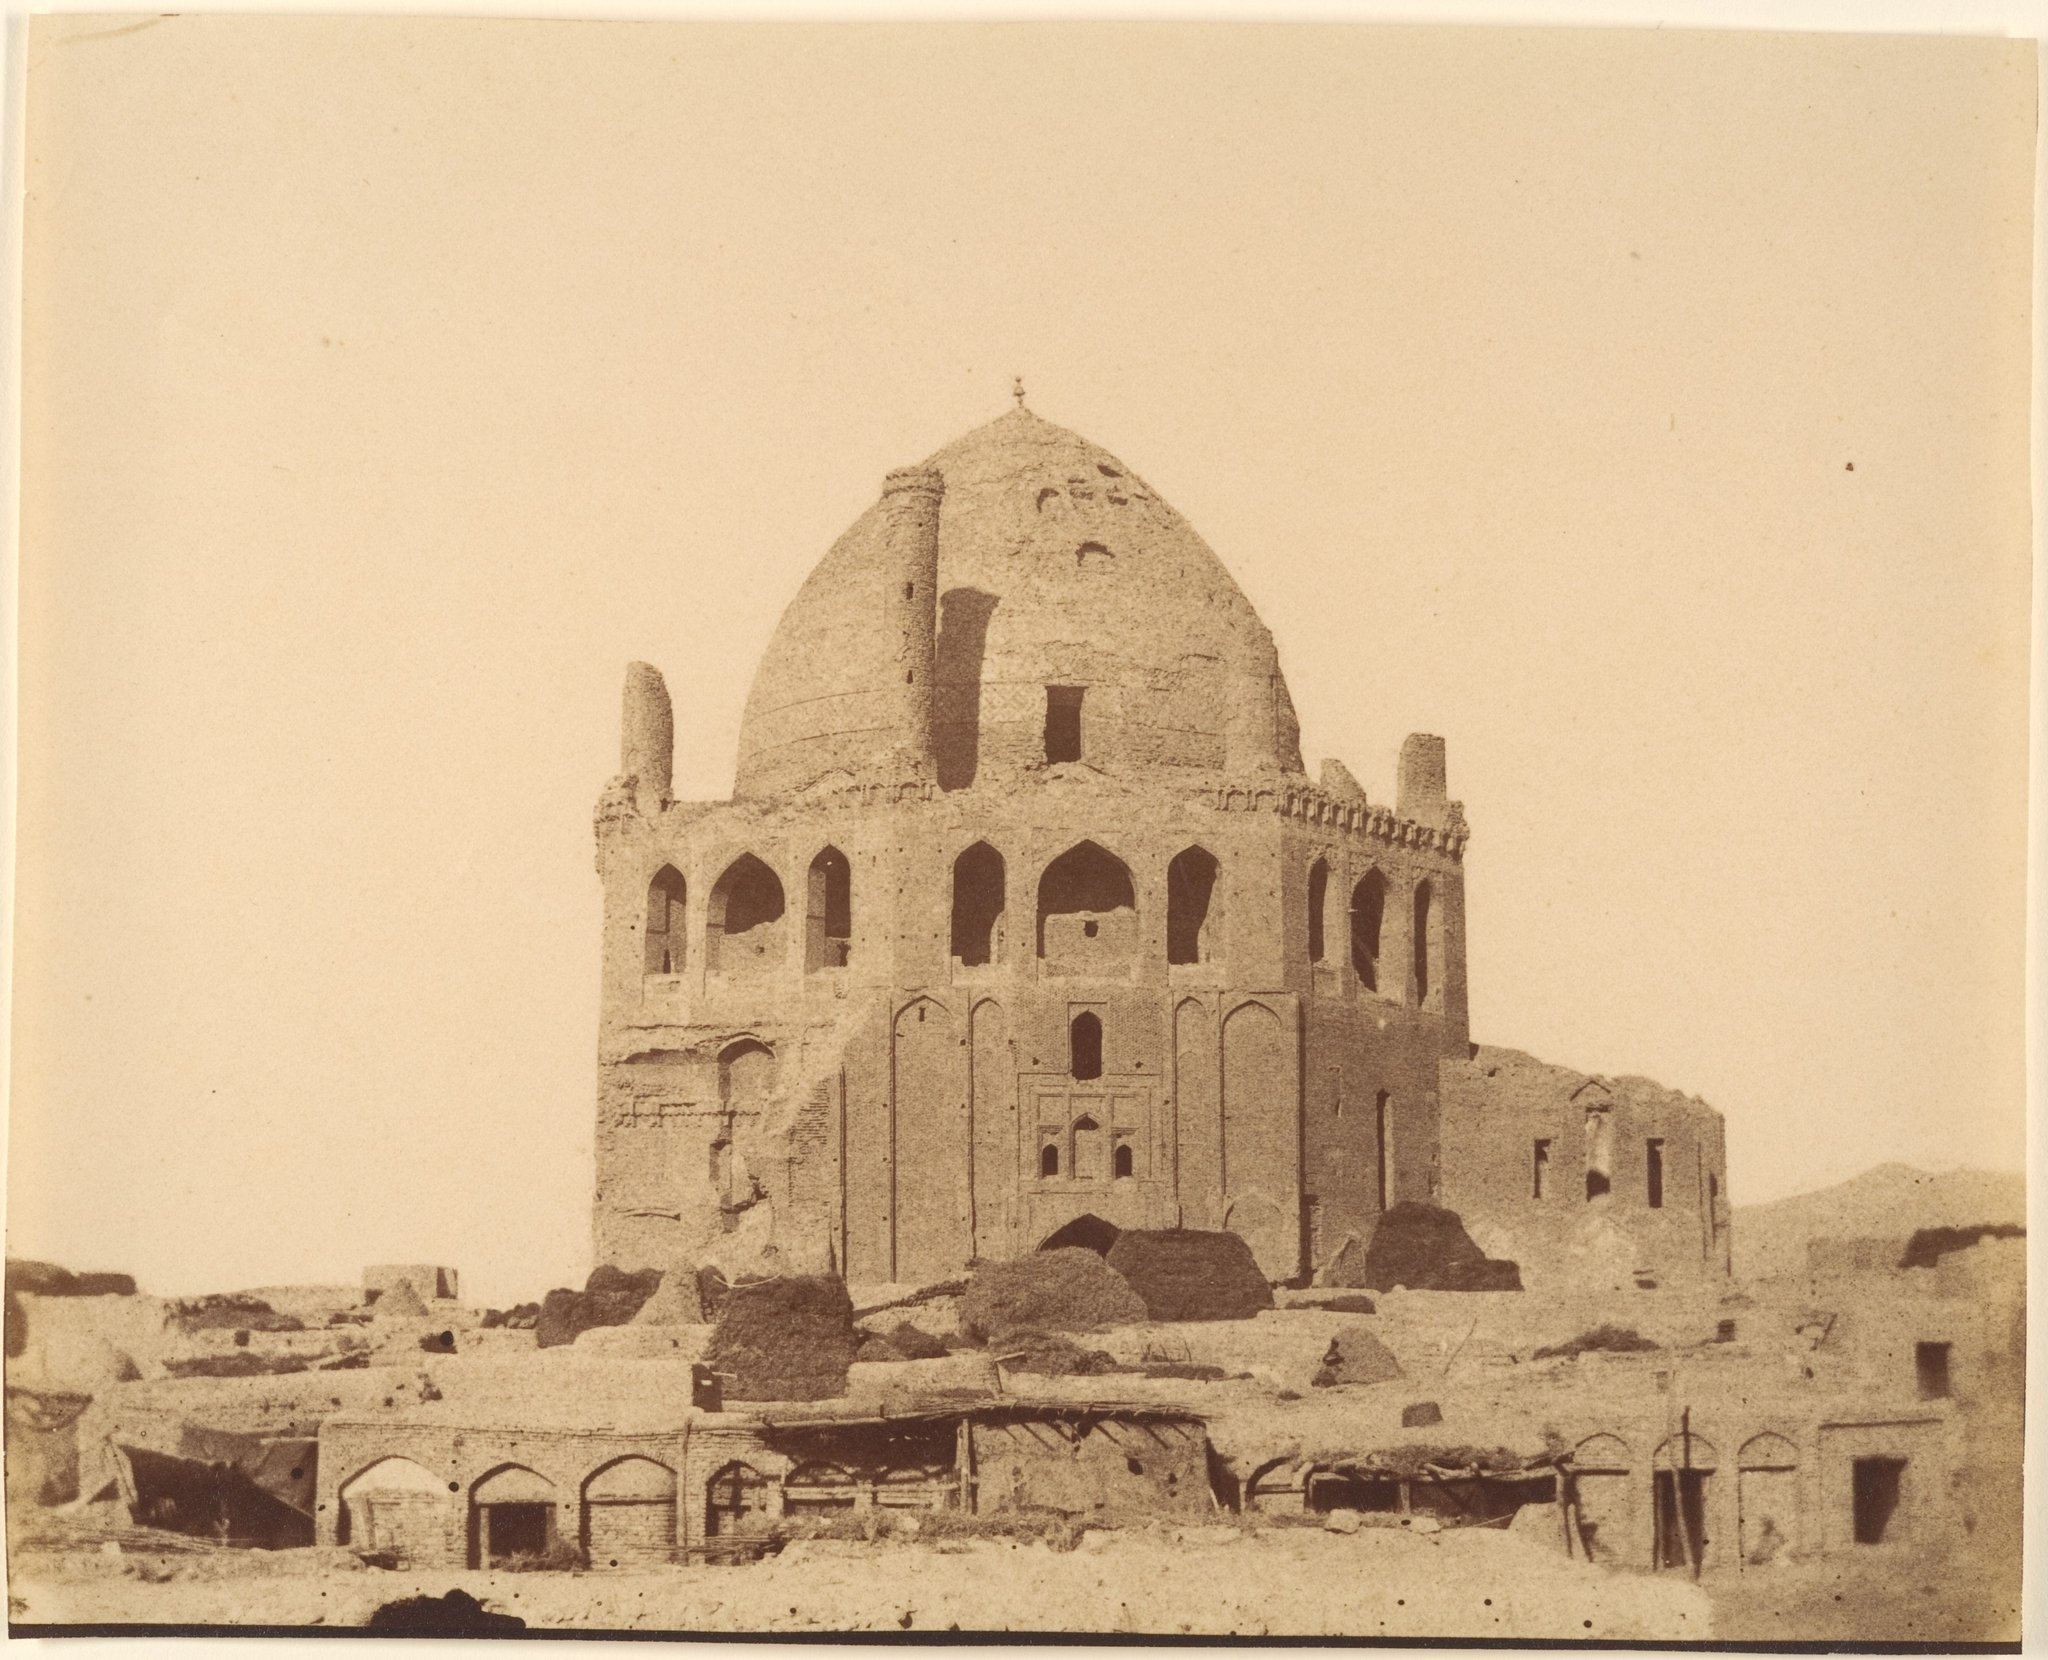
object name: photograph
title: [Mosque at Sultaniye, [same as 46] ]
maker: luigi pesce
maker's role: artist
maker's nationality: italian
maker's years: 1818-1891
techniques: albumen silver print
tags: architecture,mosques